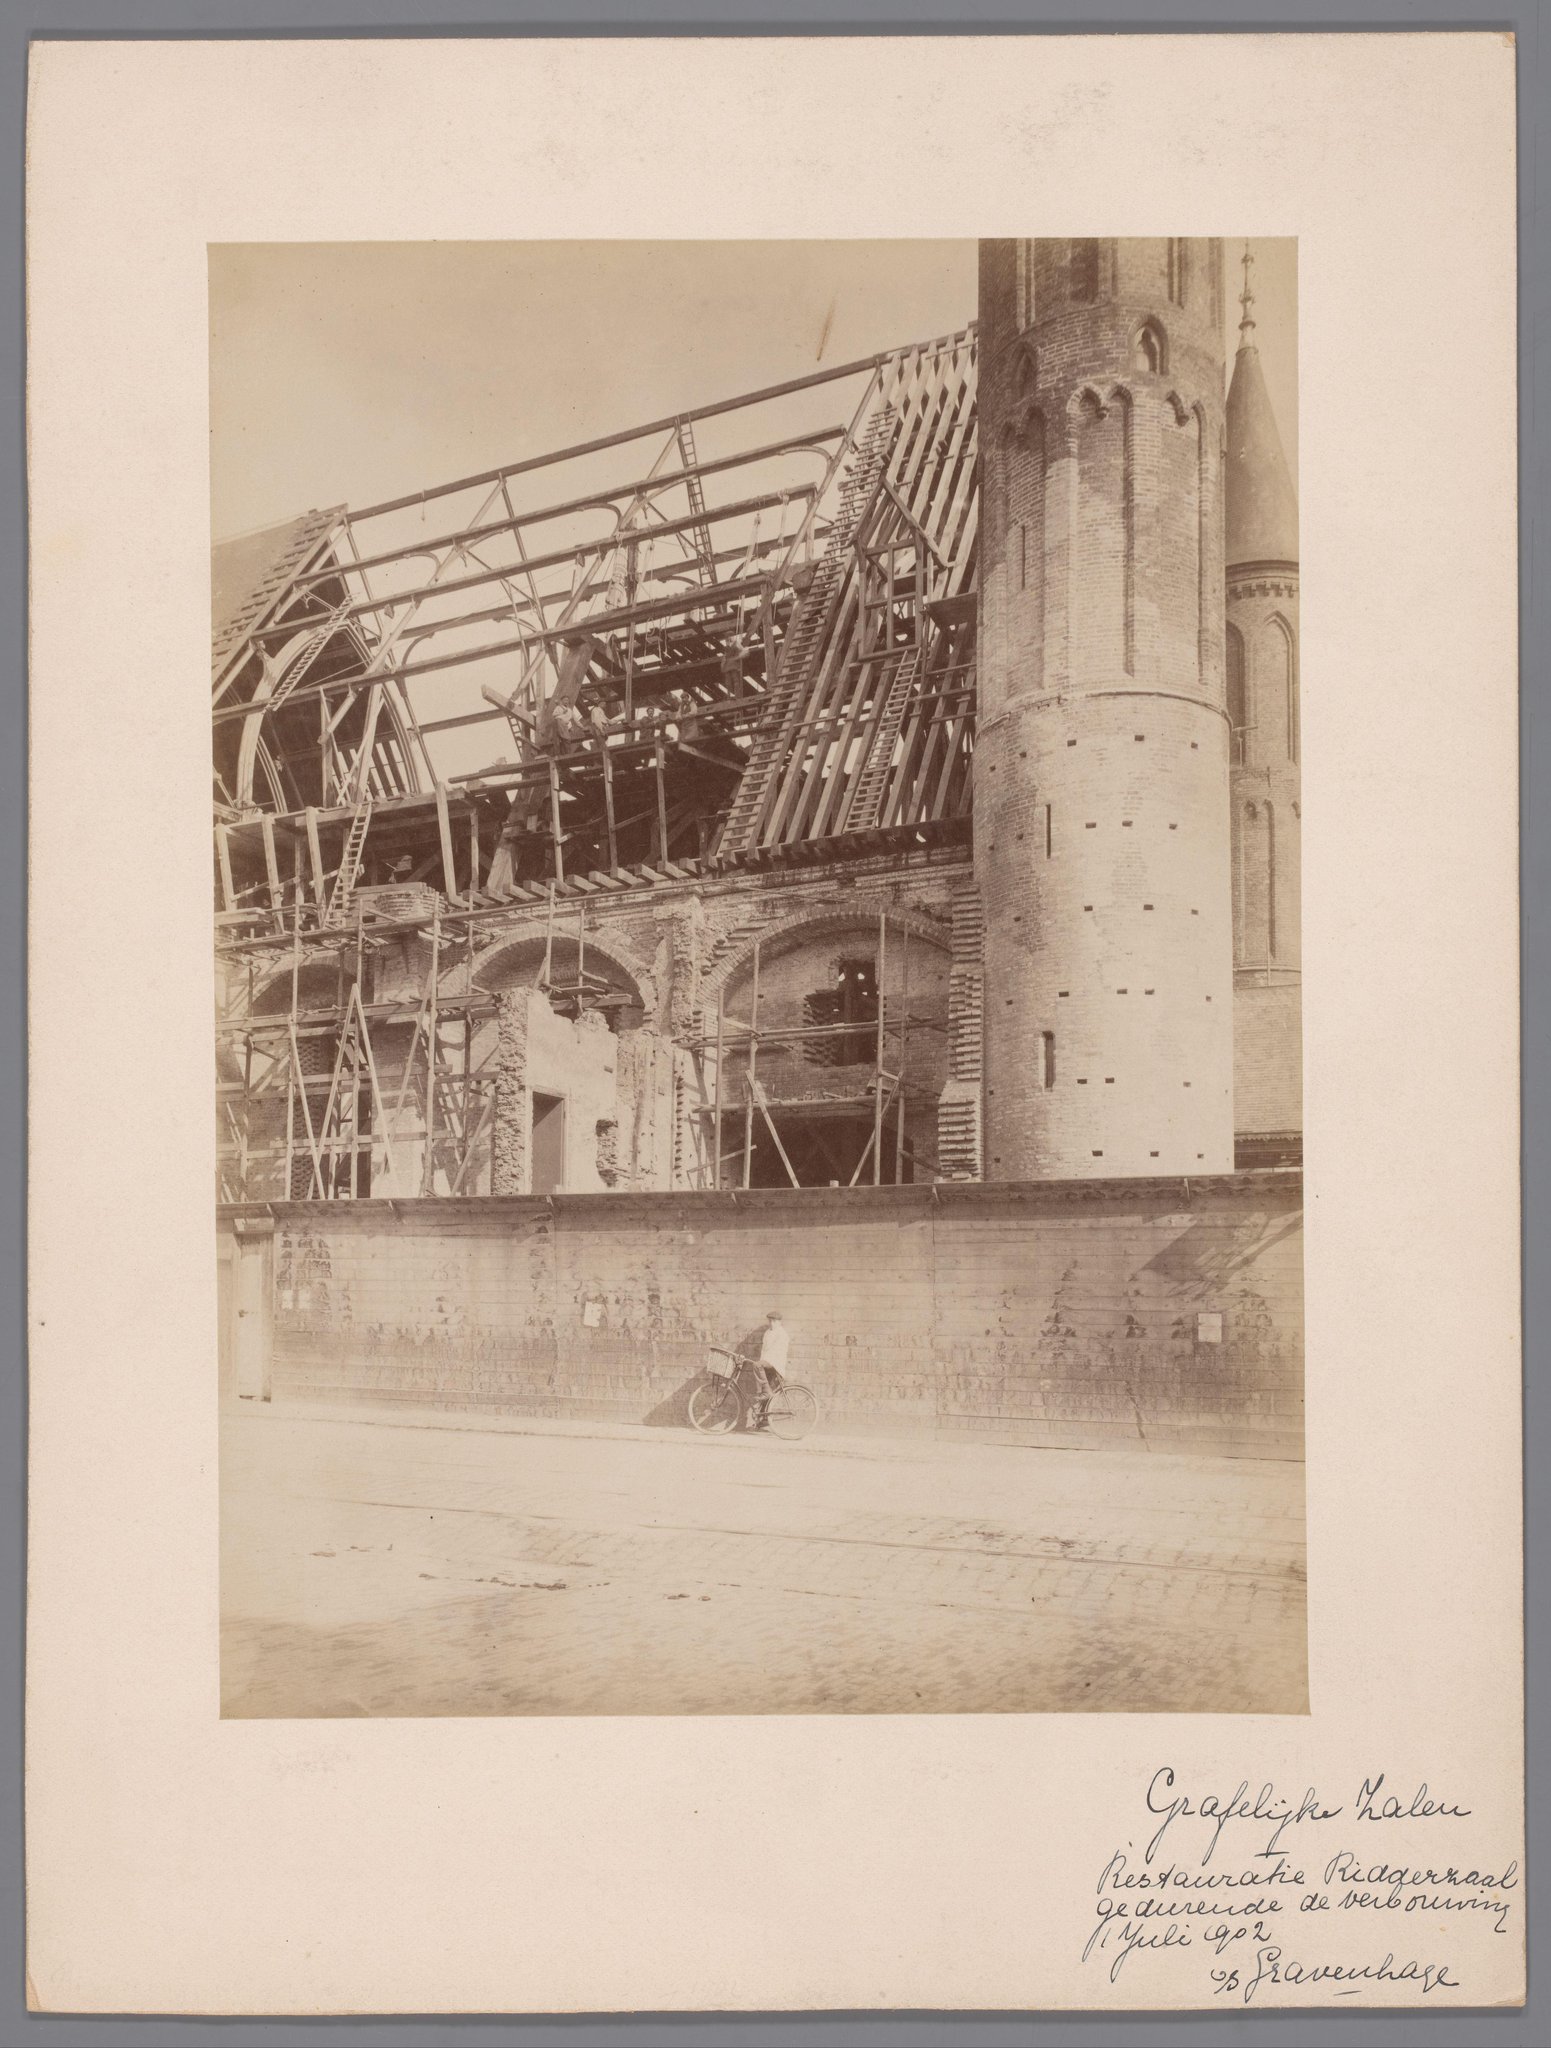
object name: photograph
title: Gezicht op de Ridderzaal tijdens de restauratie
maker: anoniem (monumentenzorg)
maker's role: fotograaf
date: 1902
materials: cardboard, photographic support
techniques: albumen print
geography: binnenhof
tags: building activities, courtyard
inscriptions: annotation: ‘Grafelijke Zalen/ Restauratie Ridderzaal gedurende de verbouwing/ Juli 1902/ 's Gravenhage’, annotation: ‘'s Gravenhage (Z.H.)/ de Ridderzaal gedurende de verbwouing/ Juli 1902’